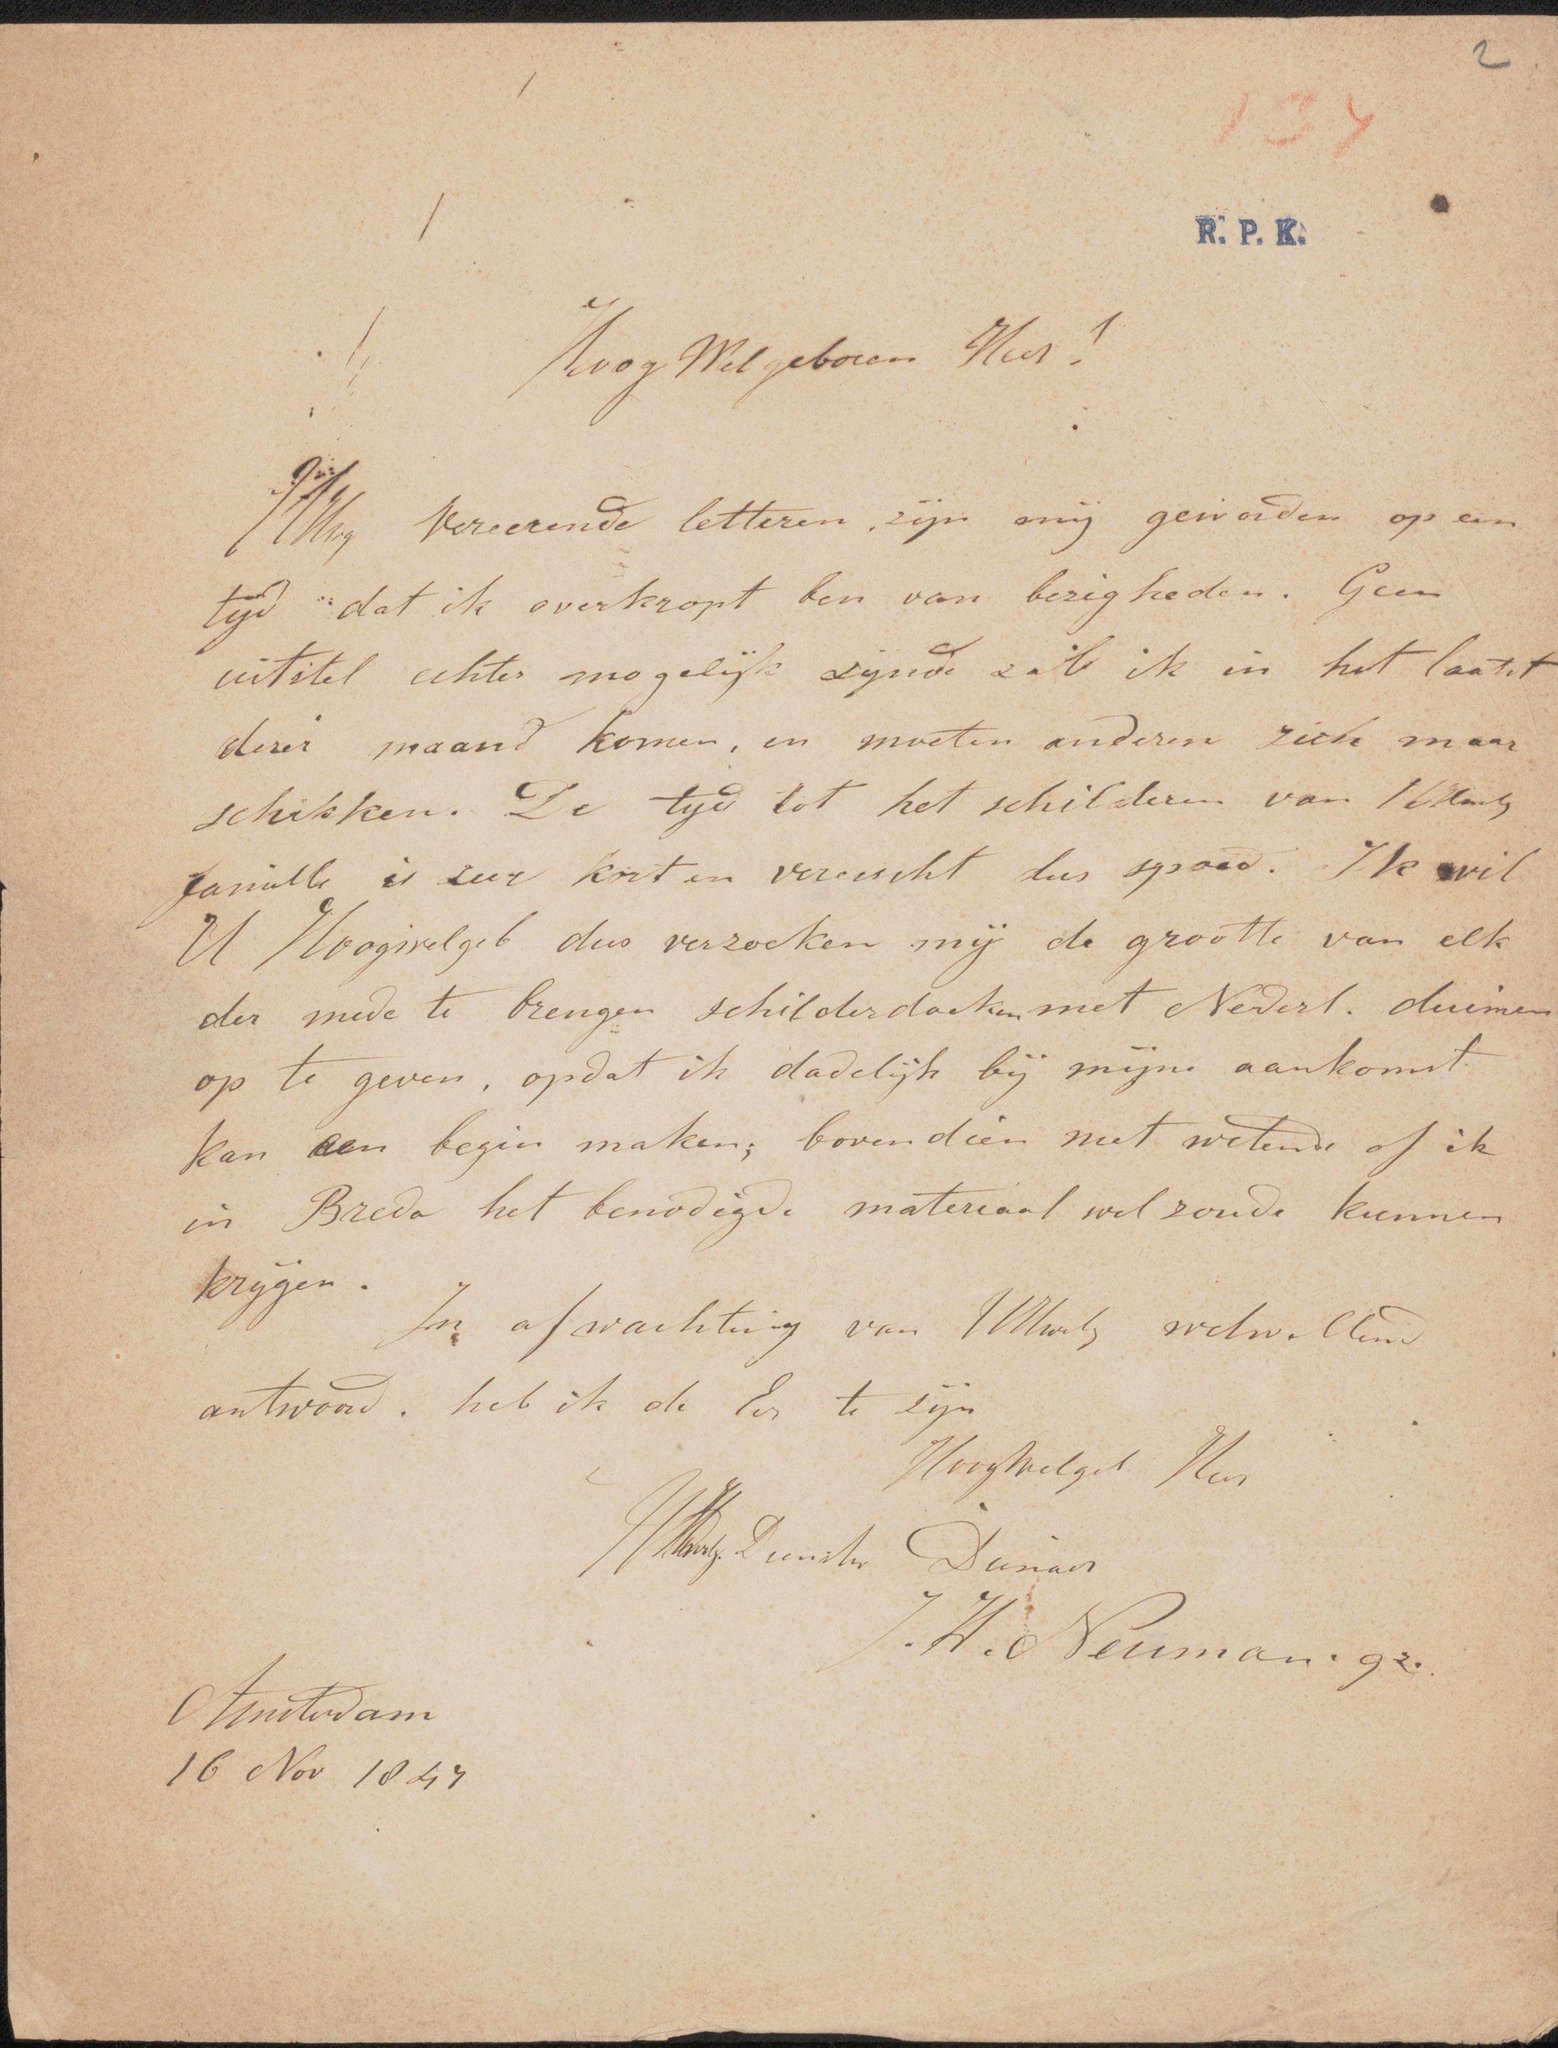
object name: letter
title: Brief aan baron Huibert Gerard Nahuys van Burgst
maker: johan heinrich neuman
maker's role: draughtsman, painter, print maker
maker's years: 1819-1898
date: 1847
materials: ink, paper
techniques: pen, writing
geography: amsterdam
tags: painting (including book-illumination, miniature-painting), historical persons (portraits and scenes from the life)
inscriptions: collector's mark: Lugt 2233